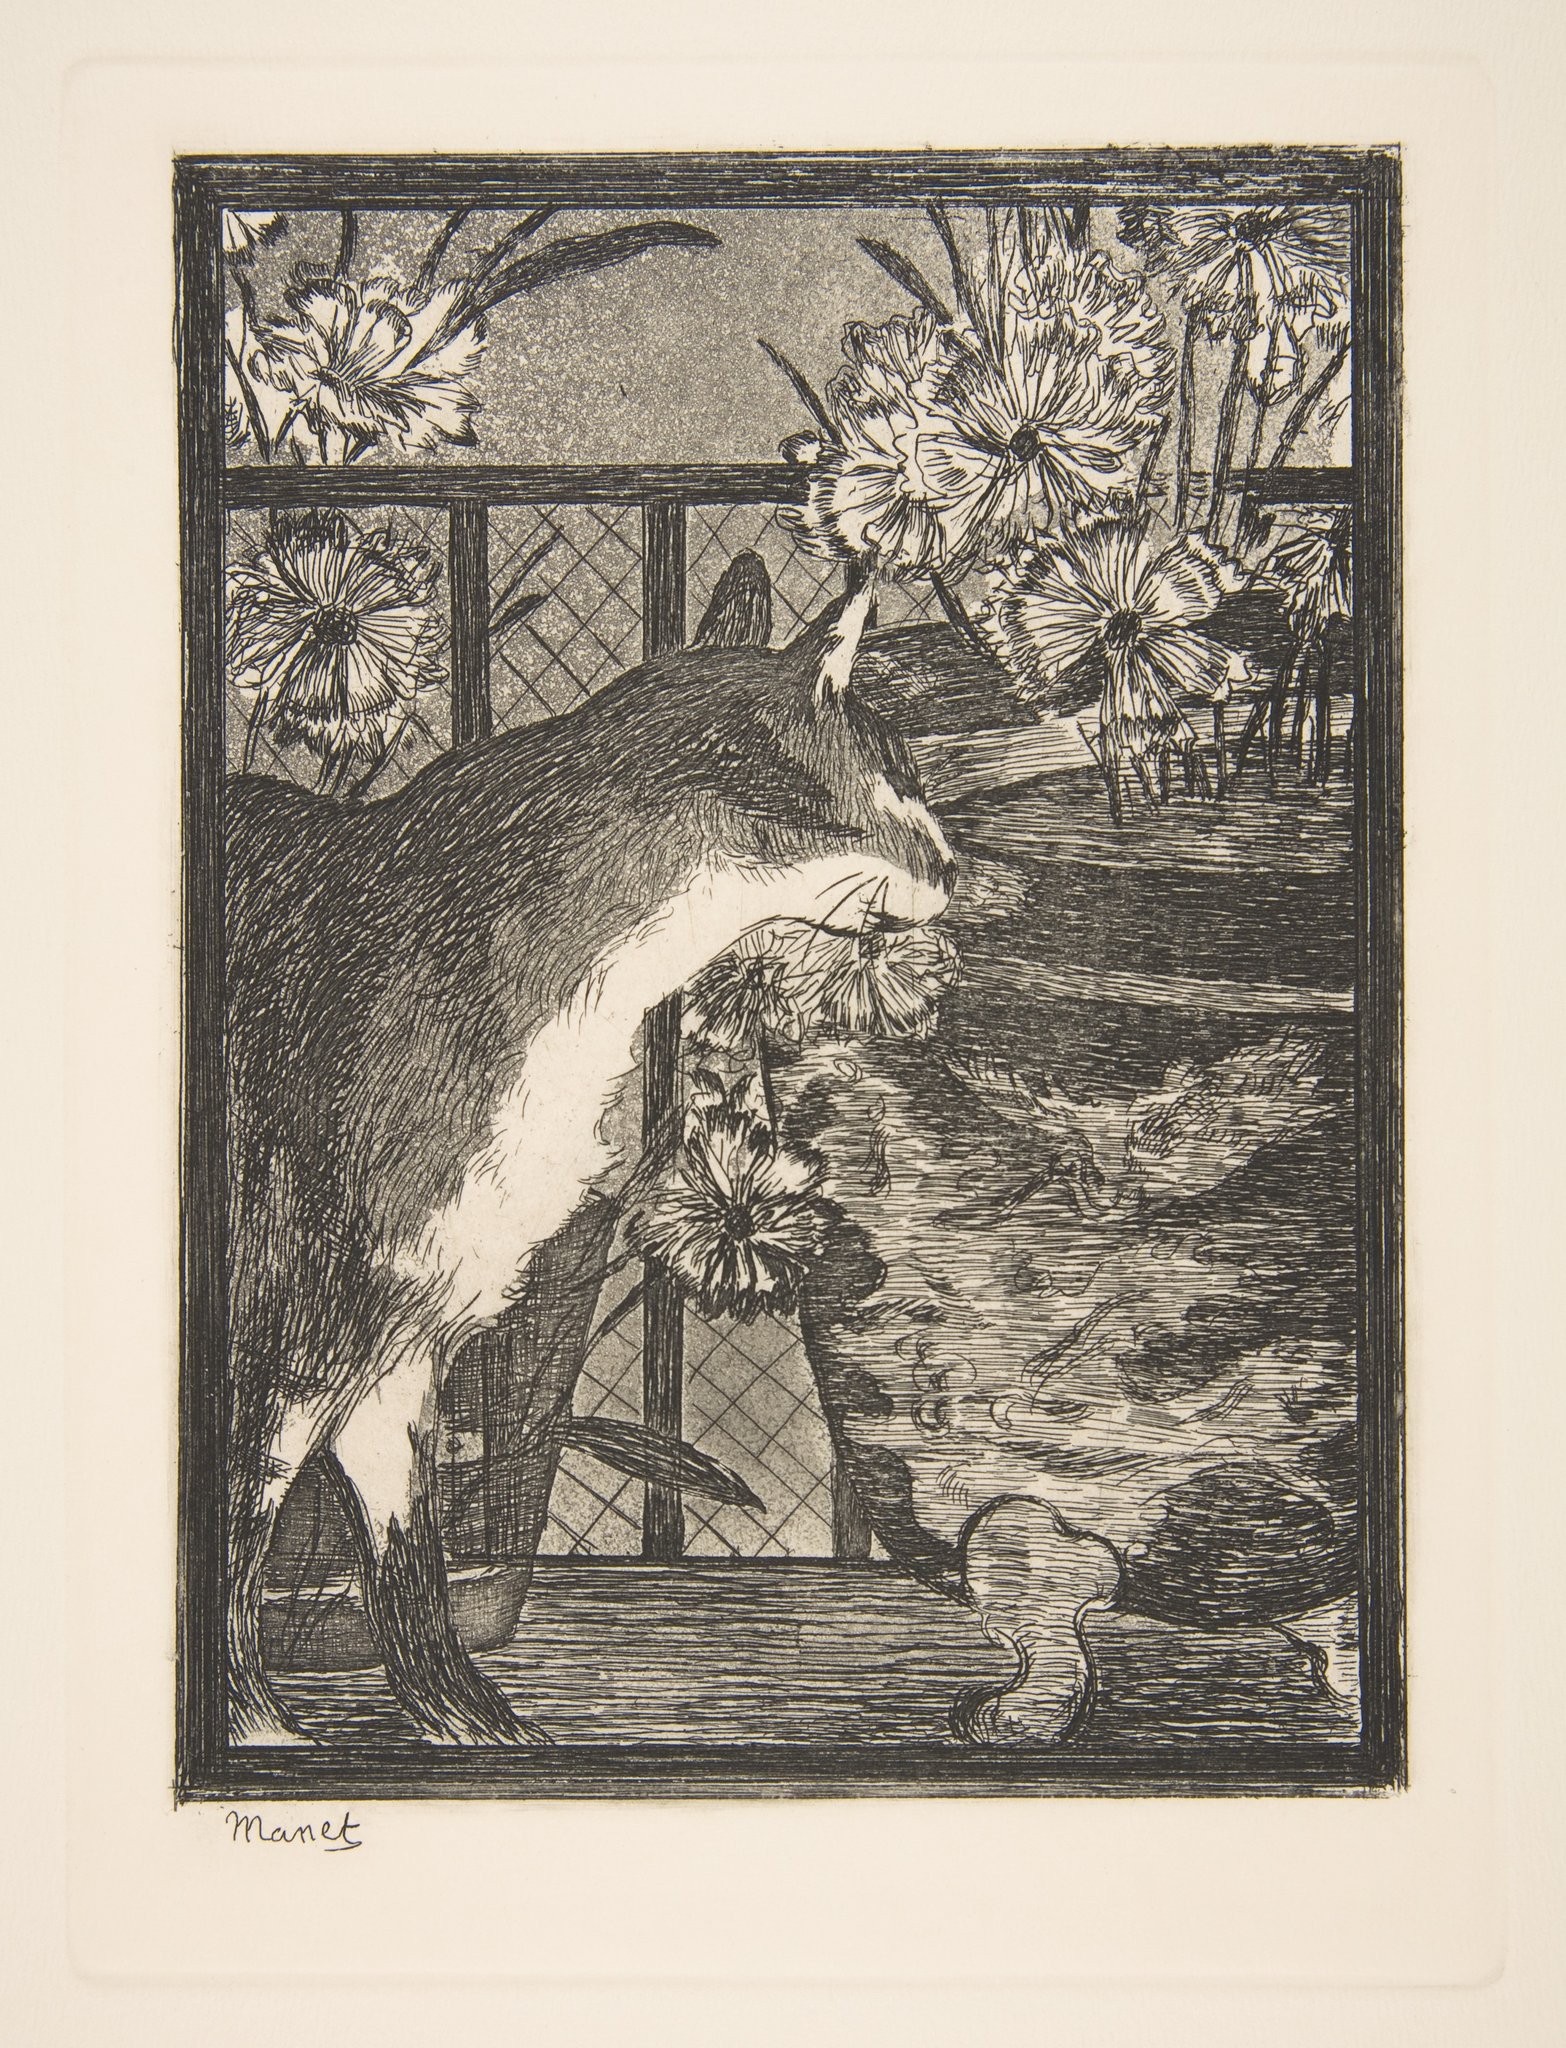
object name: print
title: Cat and Flowers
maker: édouard manet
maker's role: artist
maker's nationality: french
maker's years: 1832-1883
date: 1869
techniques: aquatint, etching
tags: cats